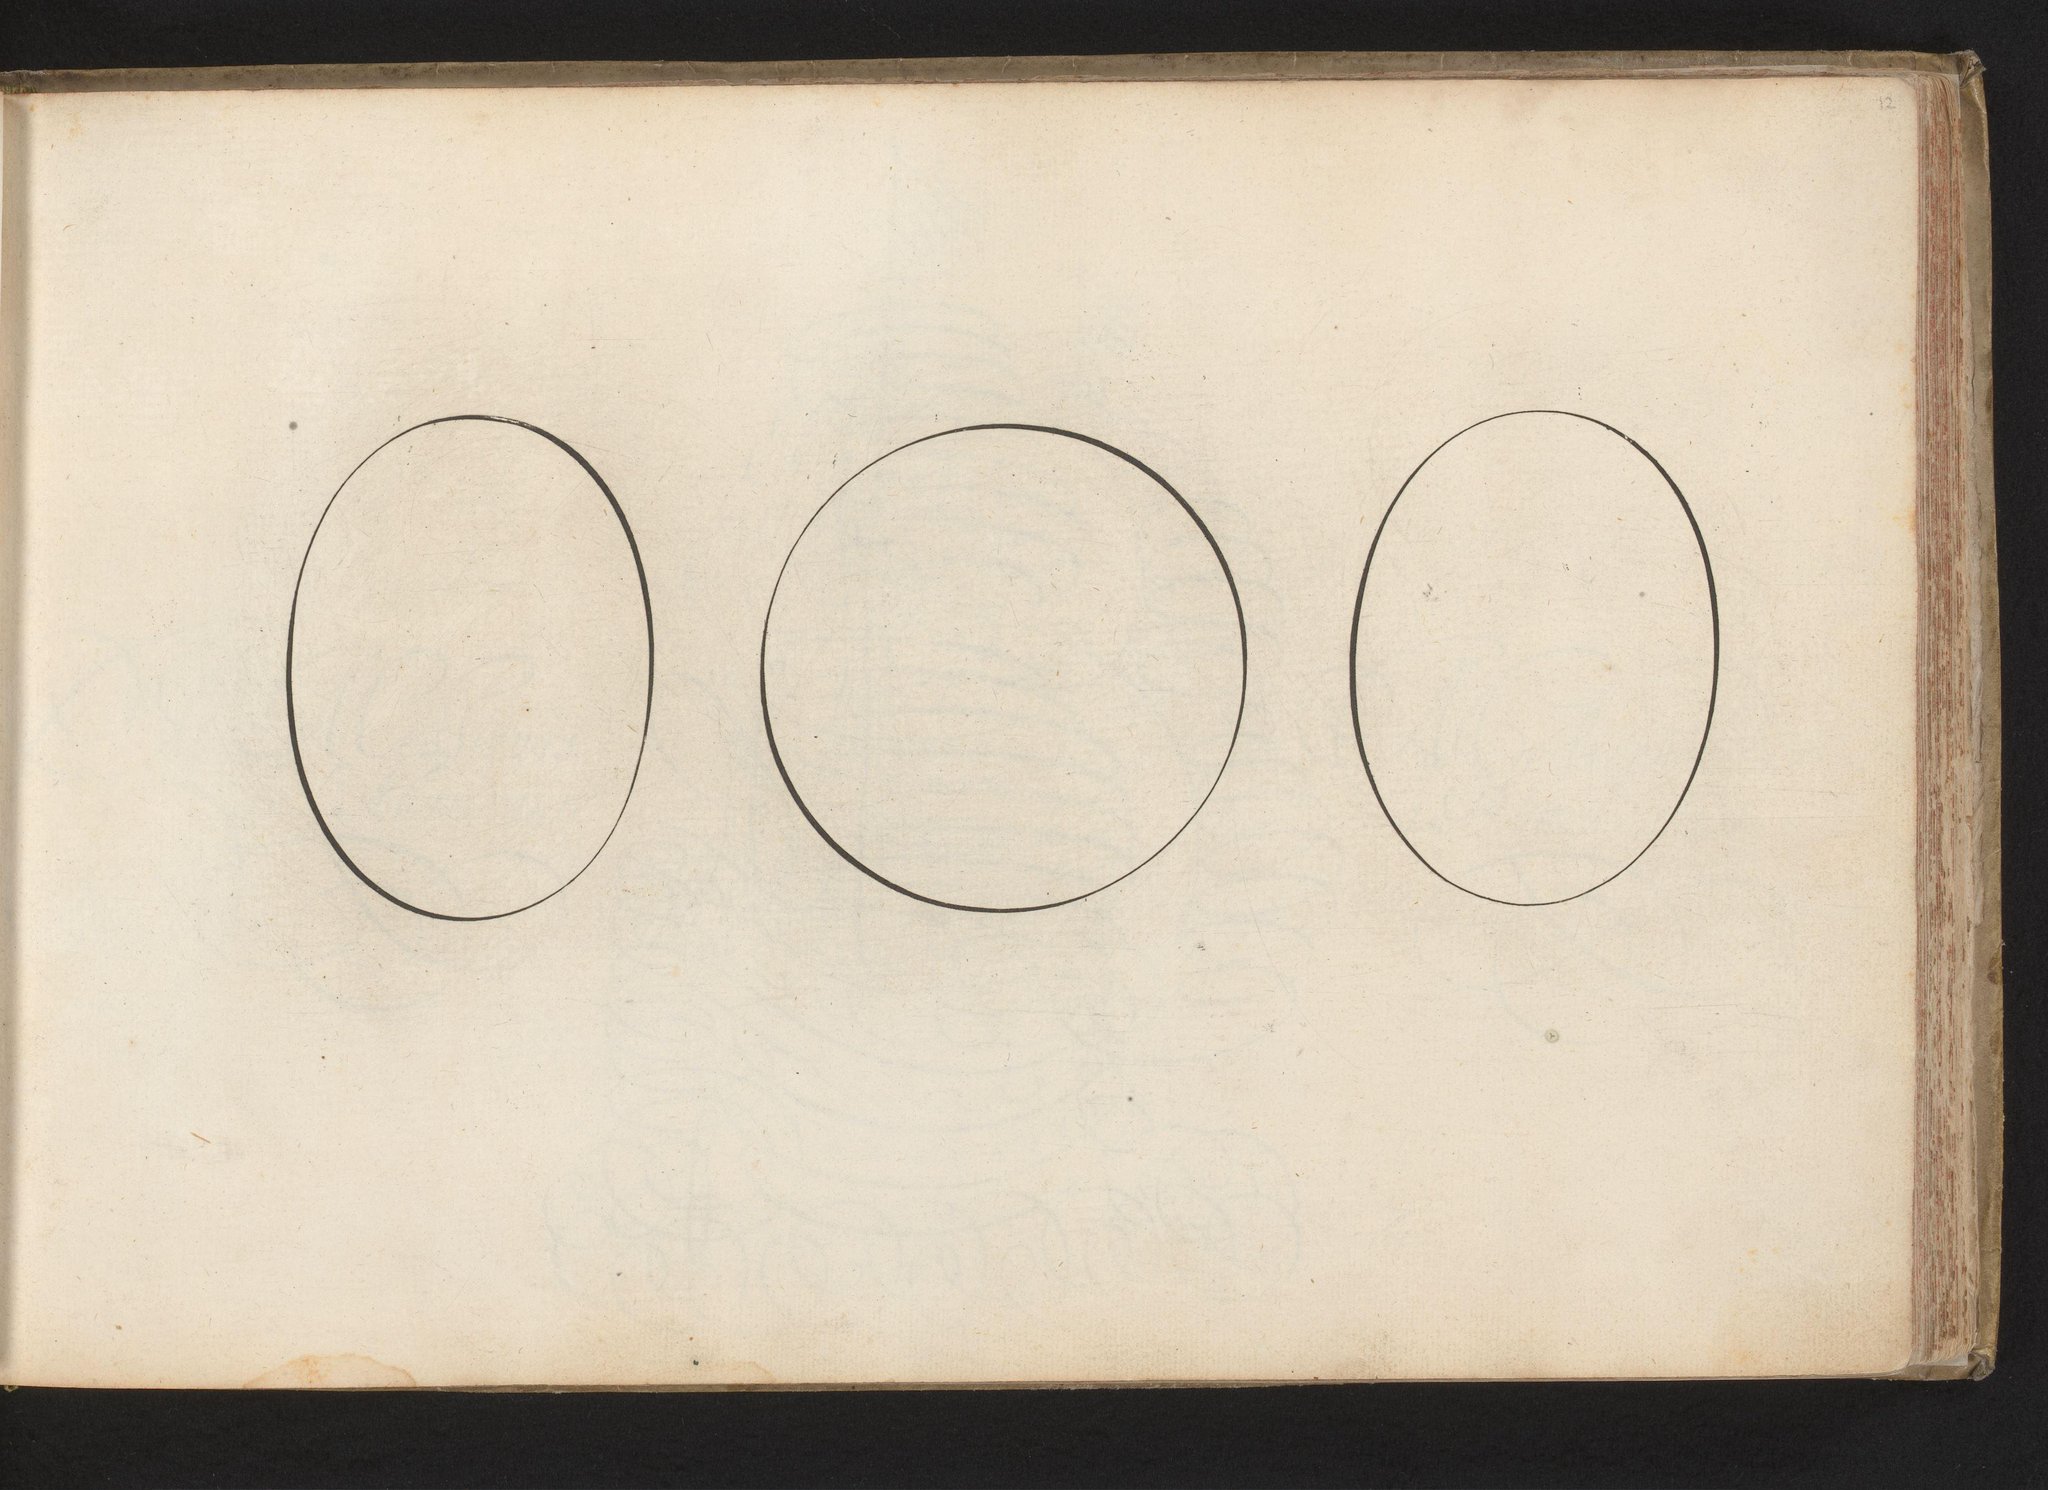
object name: album leaf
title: Drie ronde vormen, gesloten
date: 1605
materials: paper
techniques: engraving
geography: haarlem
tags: calligraphy, circle (~ planimetry, geometry)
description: Van links naar rechts: een staande ovaal, cirkel en staande ovaal. De prent maakt deel uit van een album.